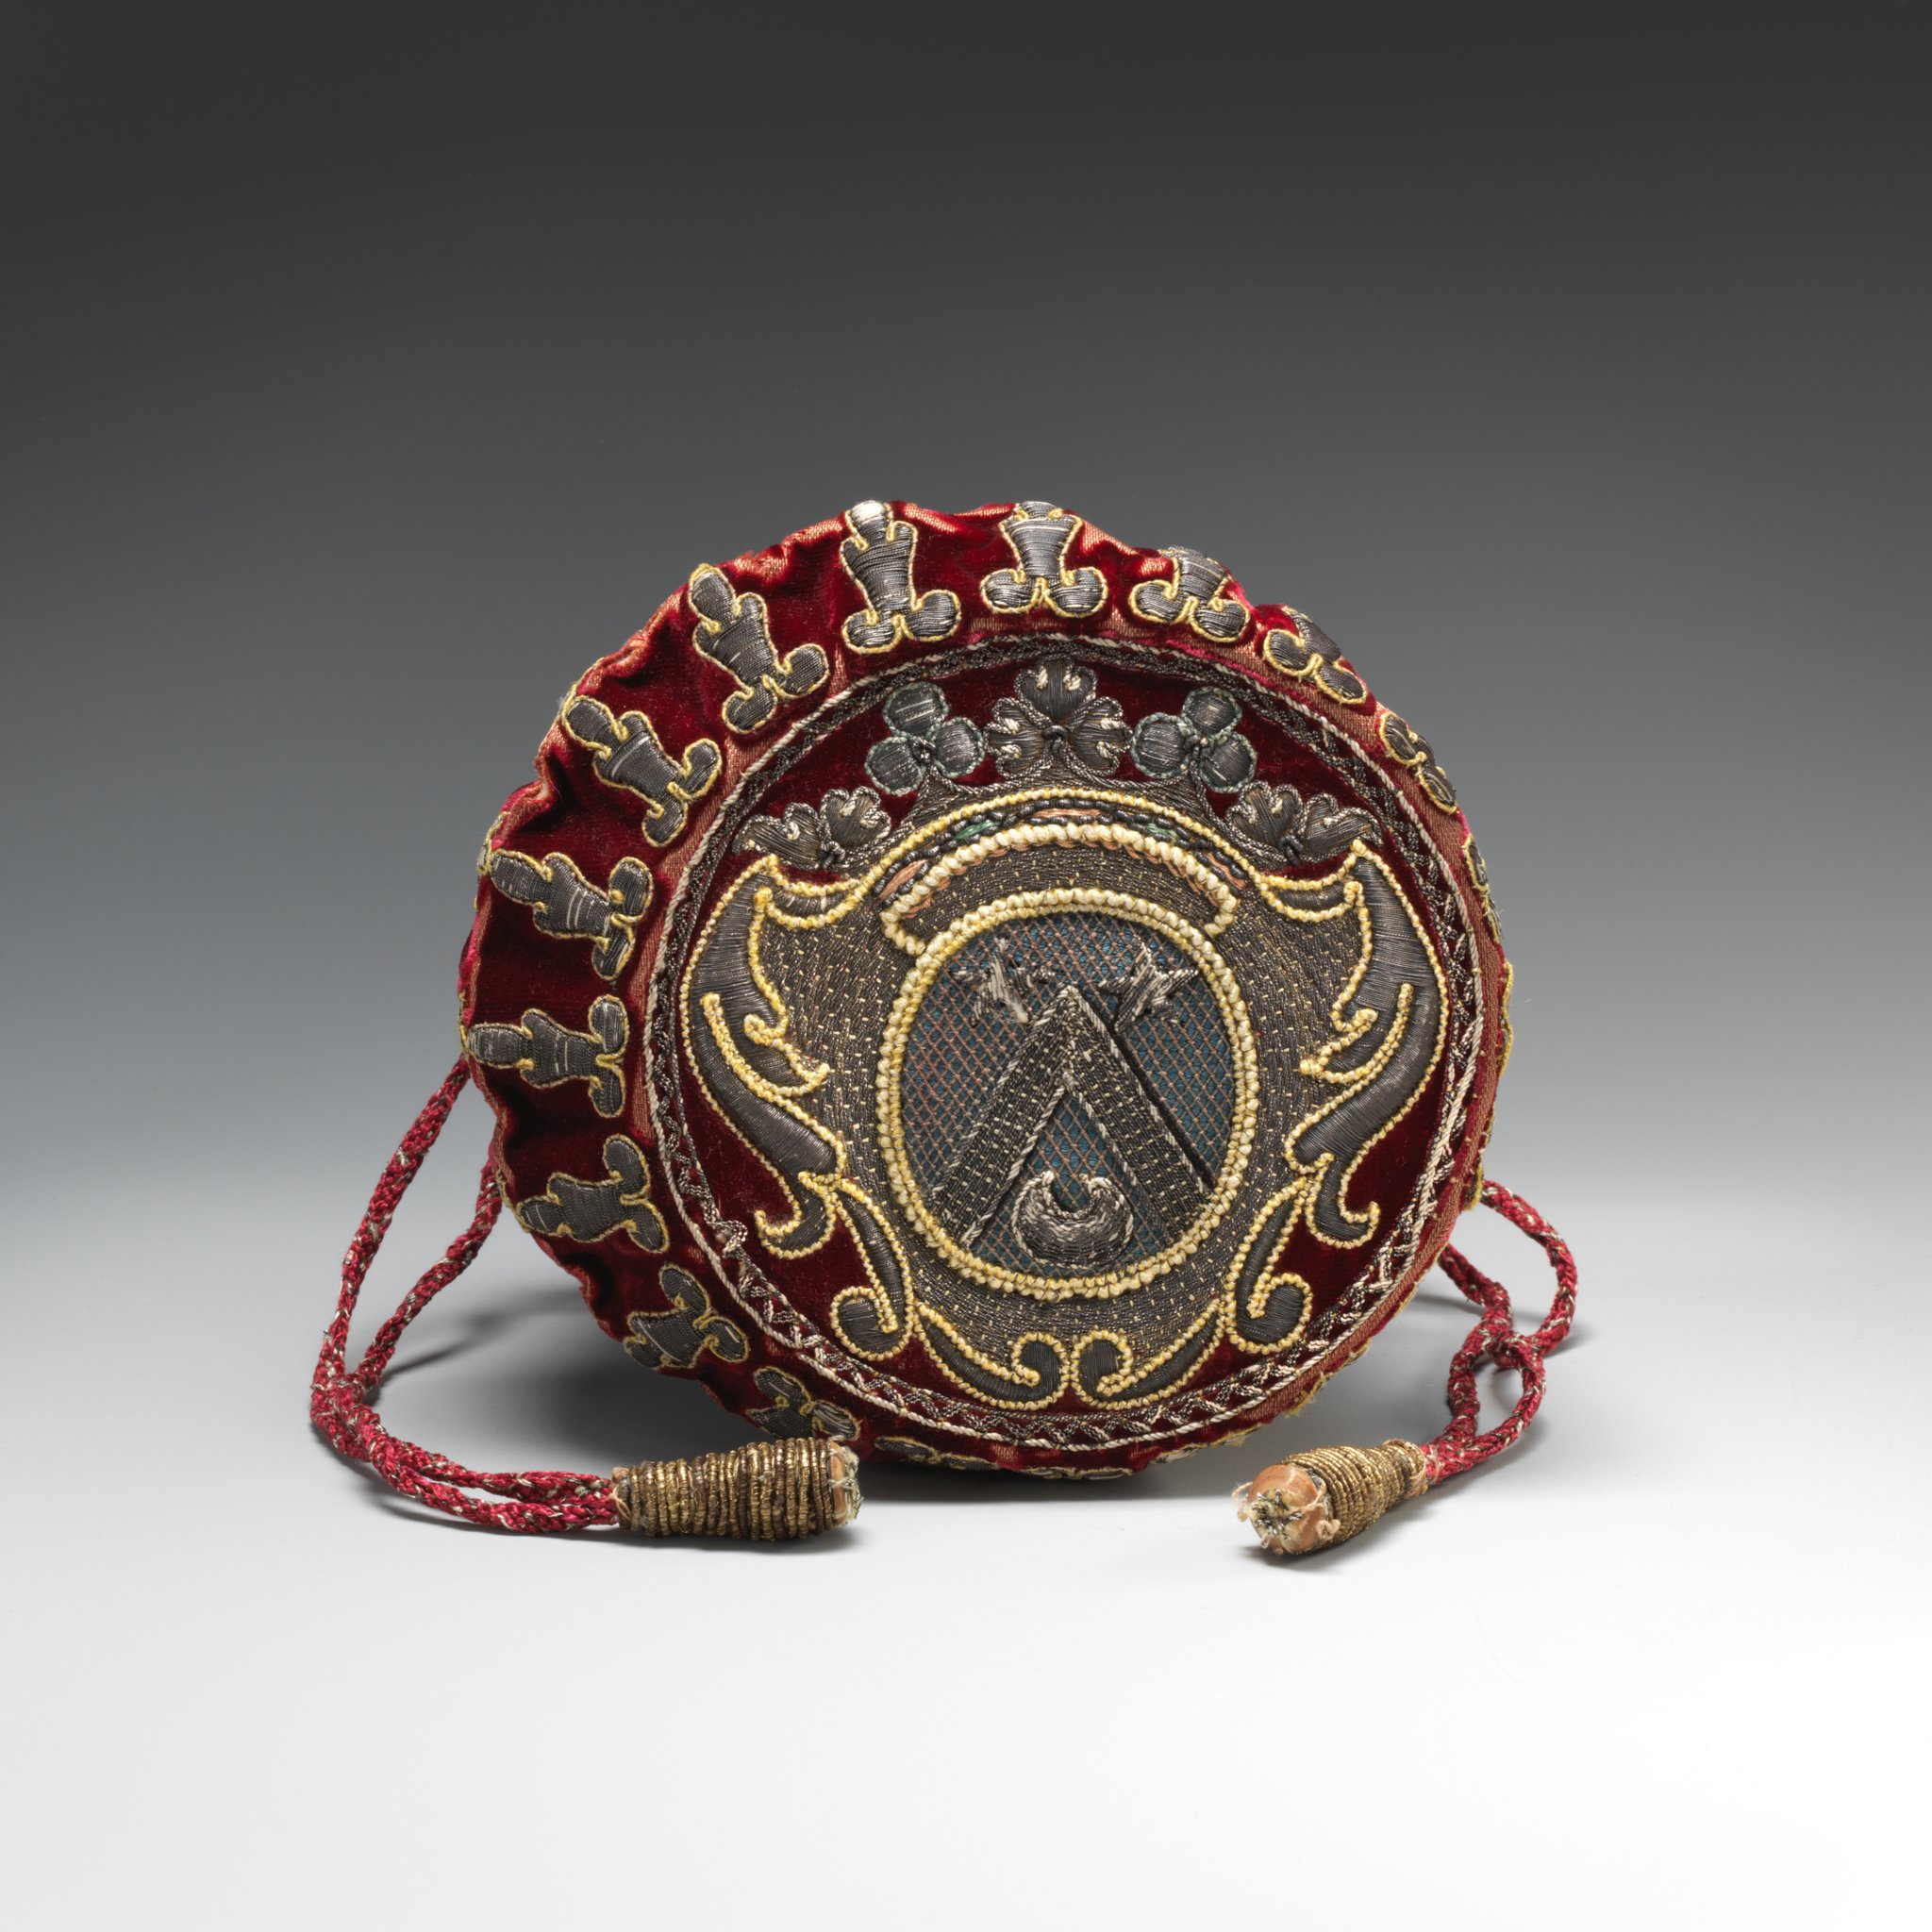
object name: purse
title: Gaming purse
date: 1667-1700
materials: silk, silver, silver gilt, thread, velvet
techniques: embroidery